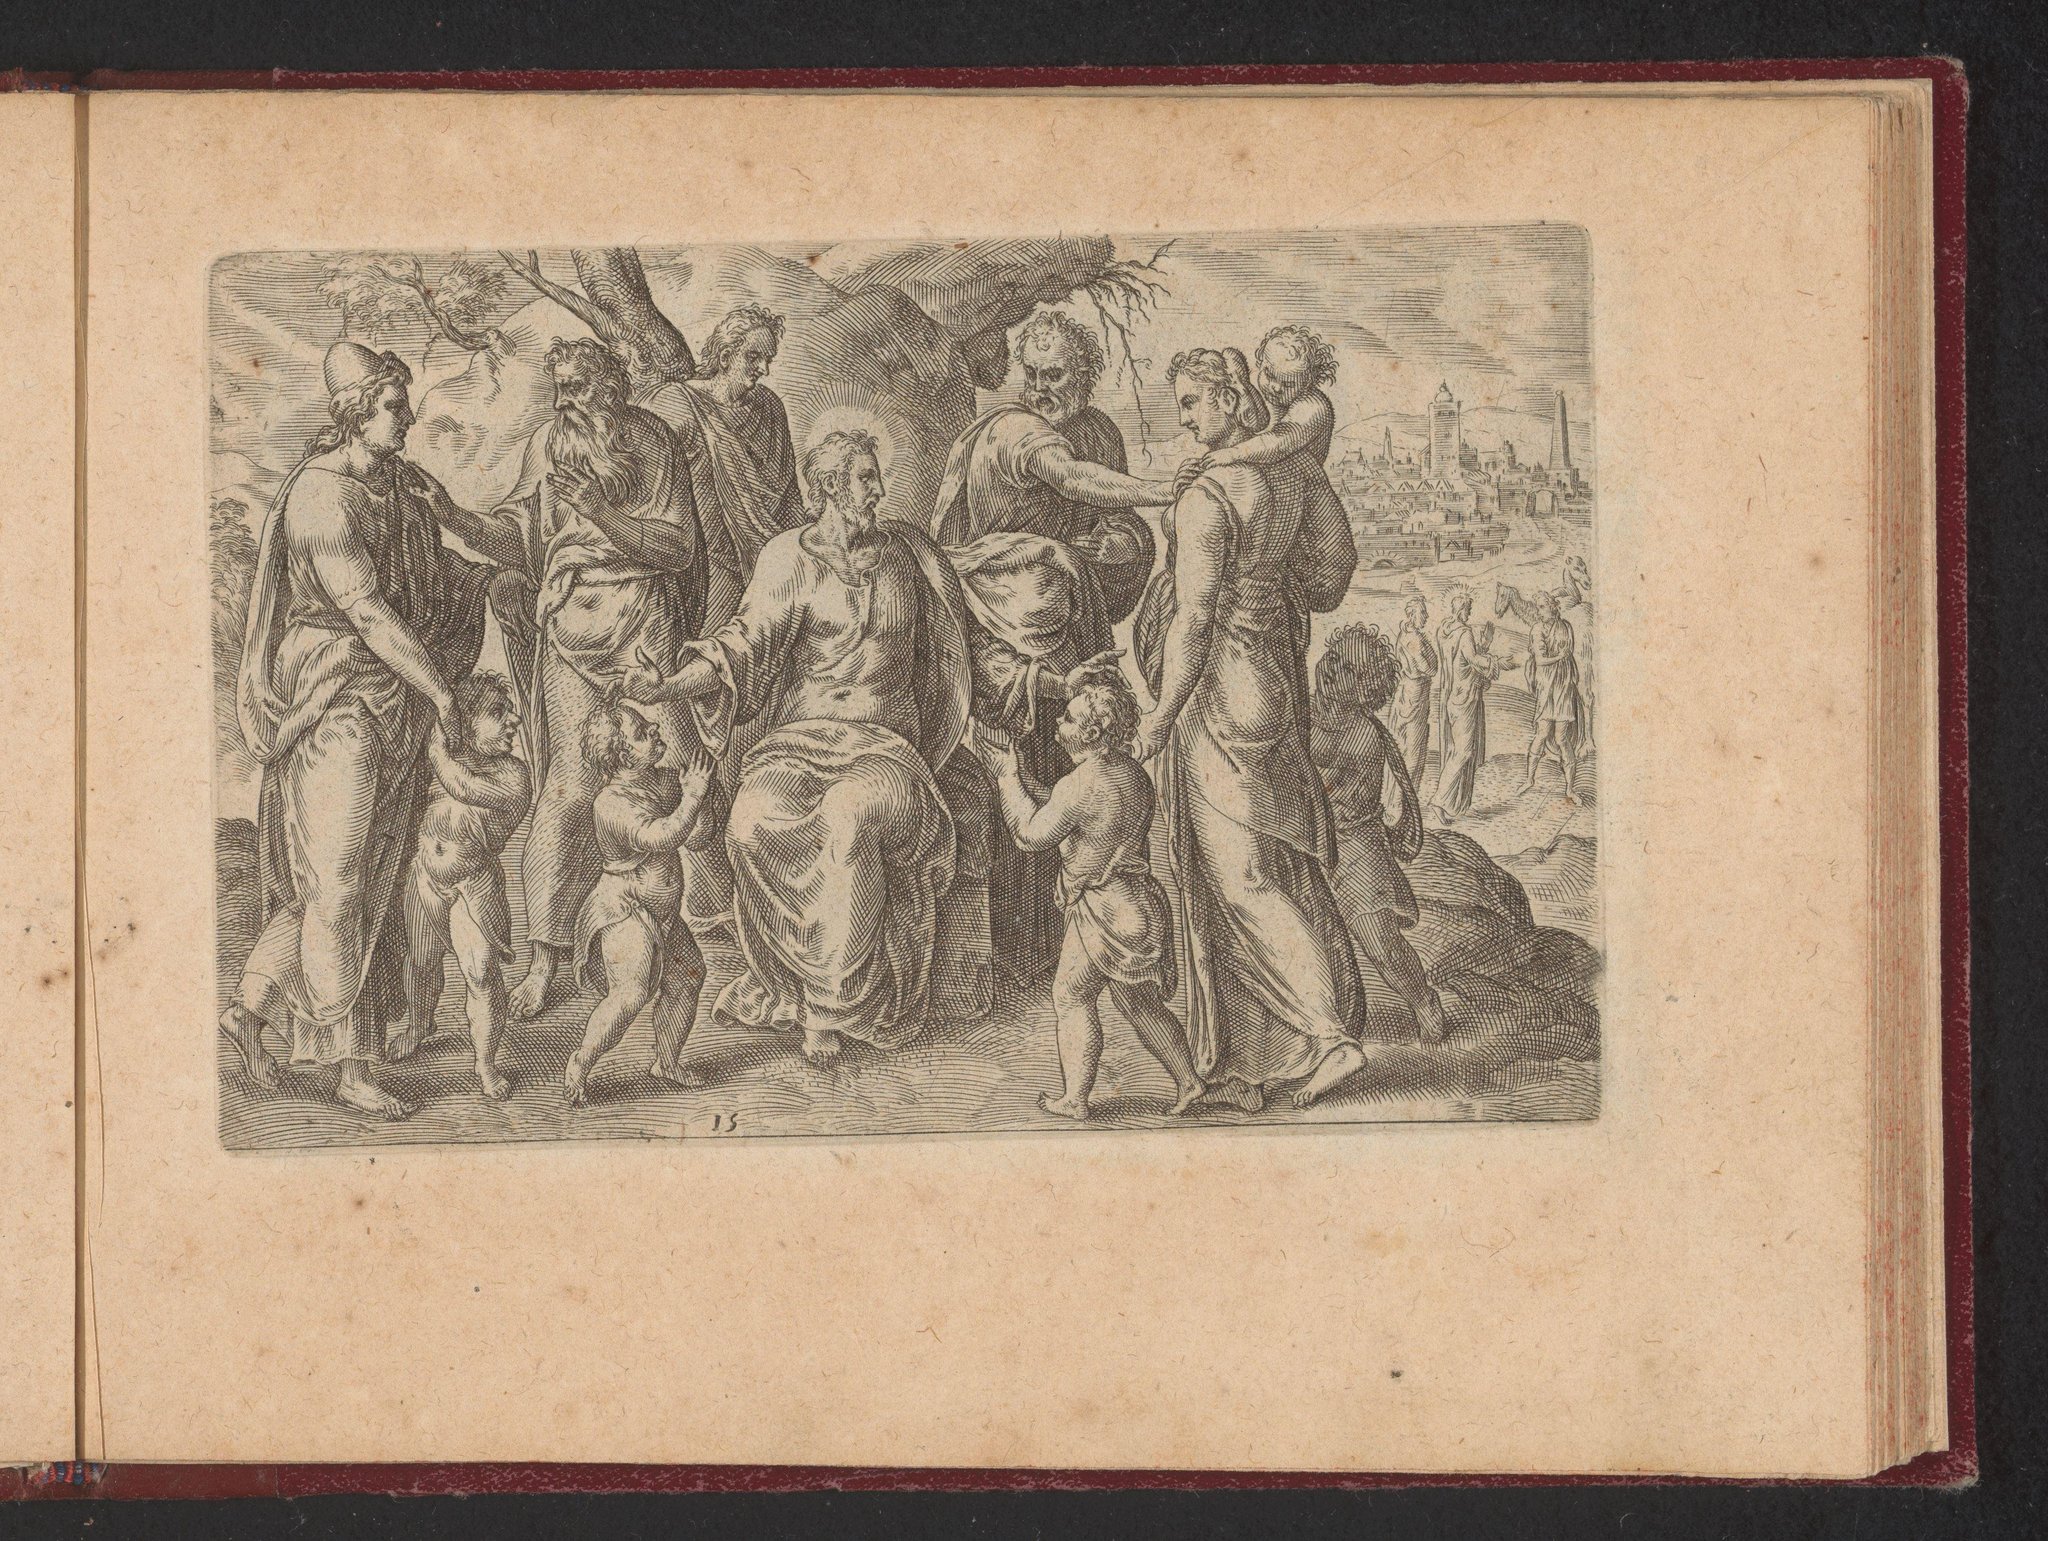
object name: print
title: Christus zegent de kinderen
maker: philips galle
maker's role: print maker, publisher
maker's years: 1537-1612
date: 1573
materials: paper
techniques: engraving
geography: antwerp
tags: christ blessing children brought by their mothers, usually with some disciples disapprovingly looking on (matthew 19:13-15; mark 10:13-16; luke 18:15-17)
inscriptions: watermark: ‘gotische letter P’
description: Onderdeel van een album met een titelprent en een serie van 50 prenten betreffende het leven en de passie van Christus.